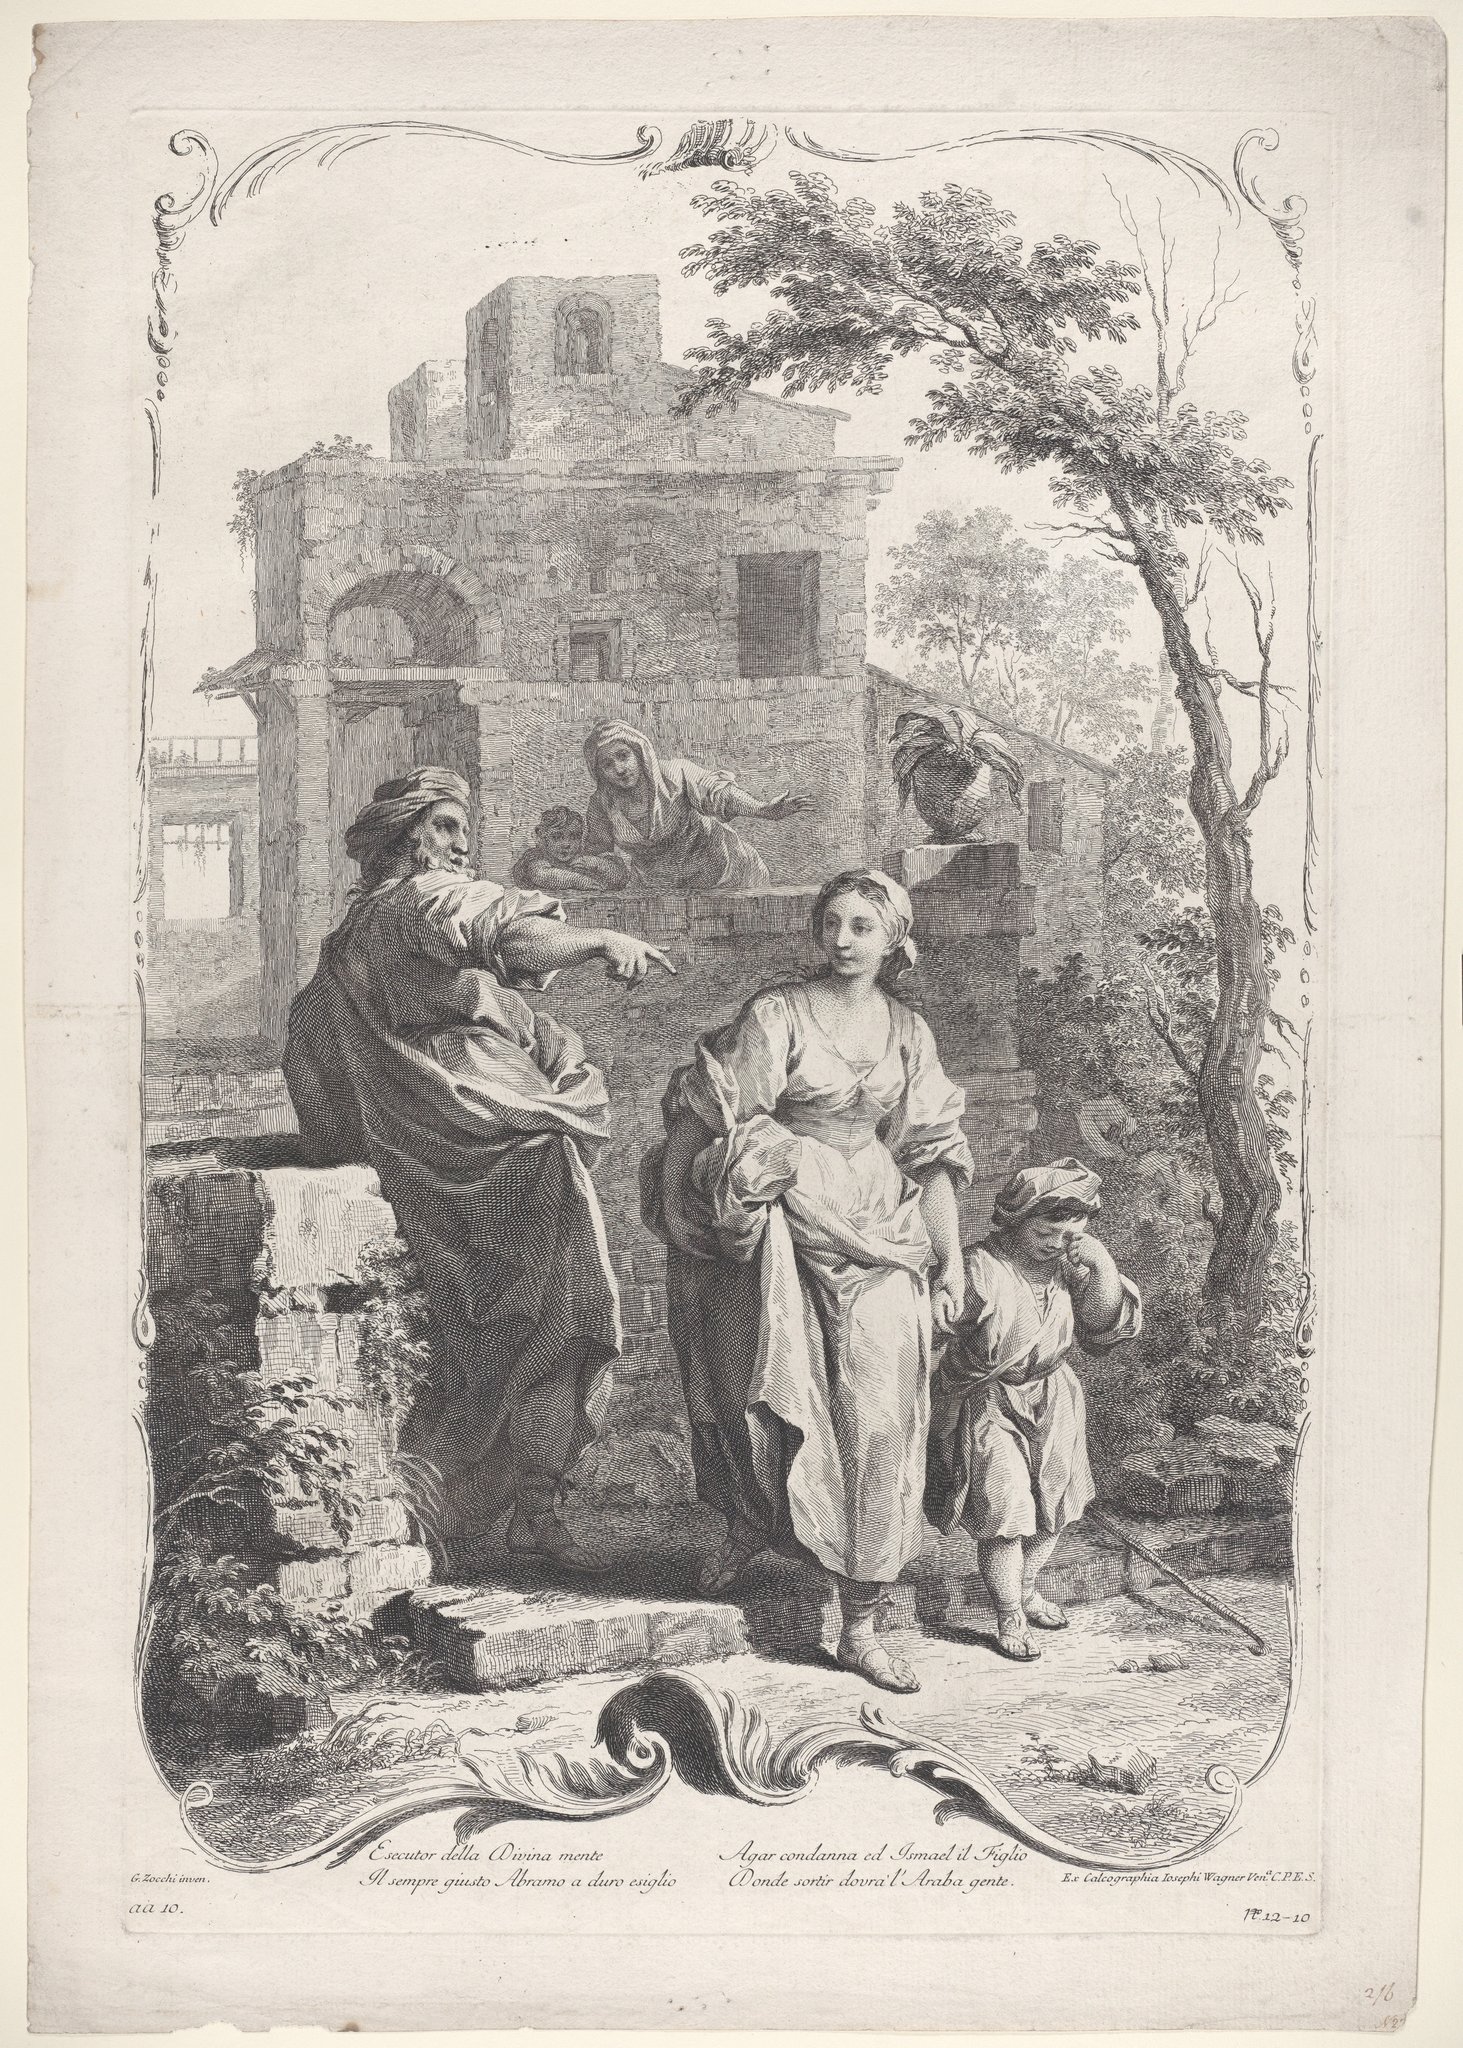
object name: print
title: Hagar Sent into the Wildnerness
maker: francesco bartolozzi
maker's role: artist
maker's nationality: italian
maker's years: 1728-1815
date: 1758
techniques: engraving, etching